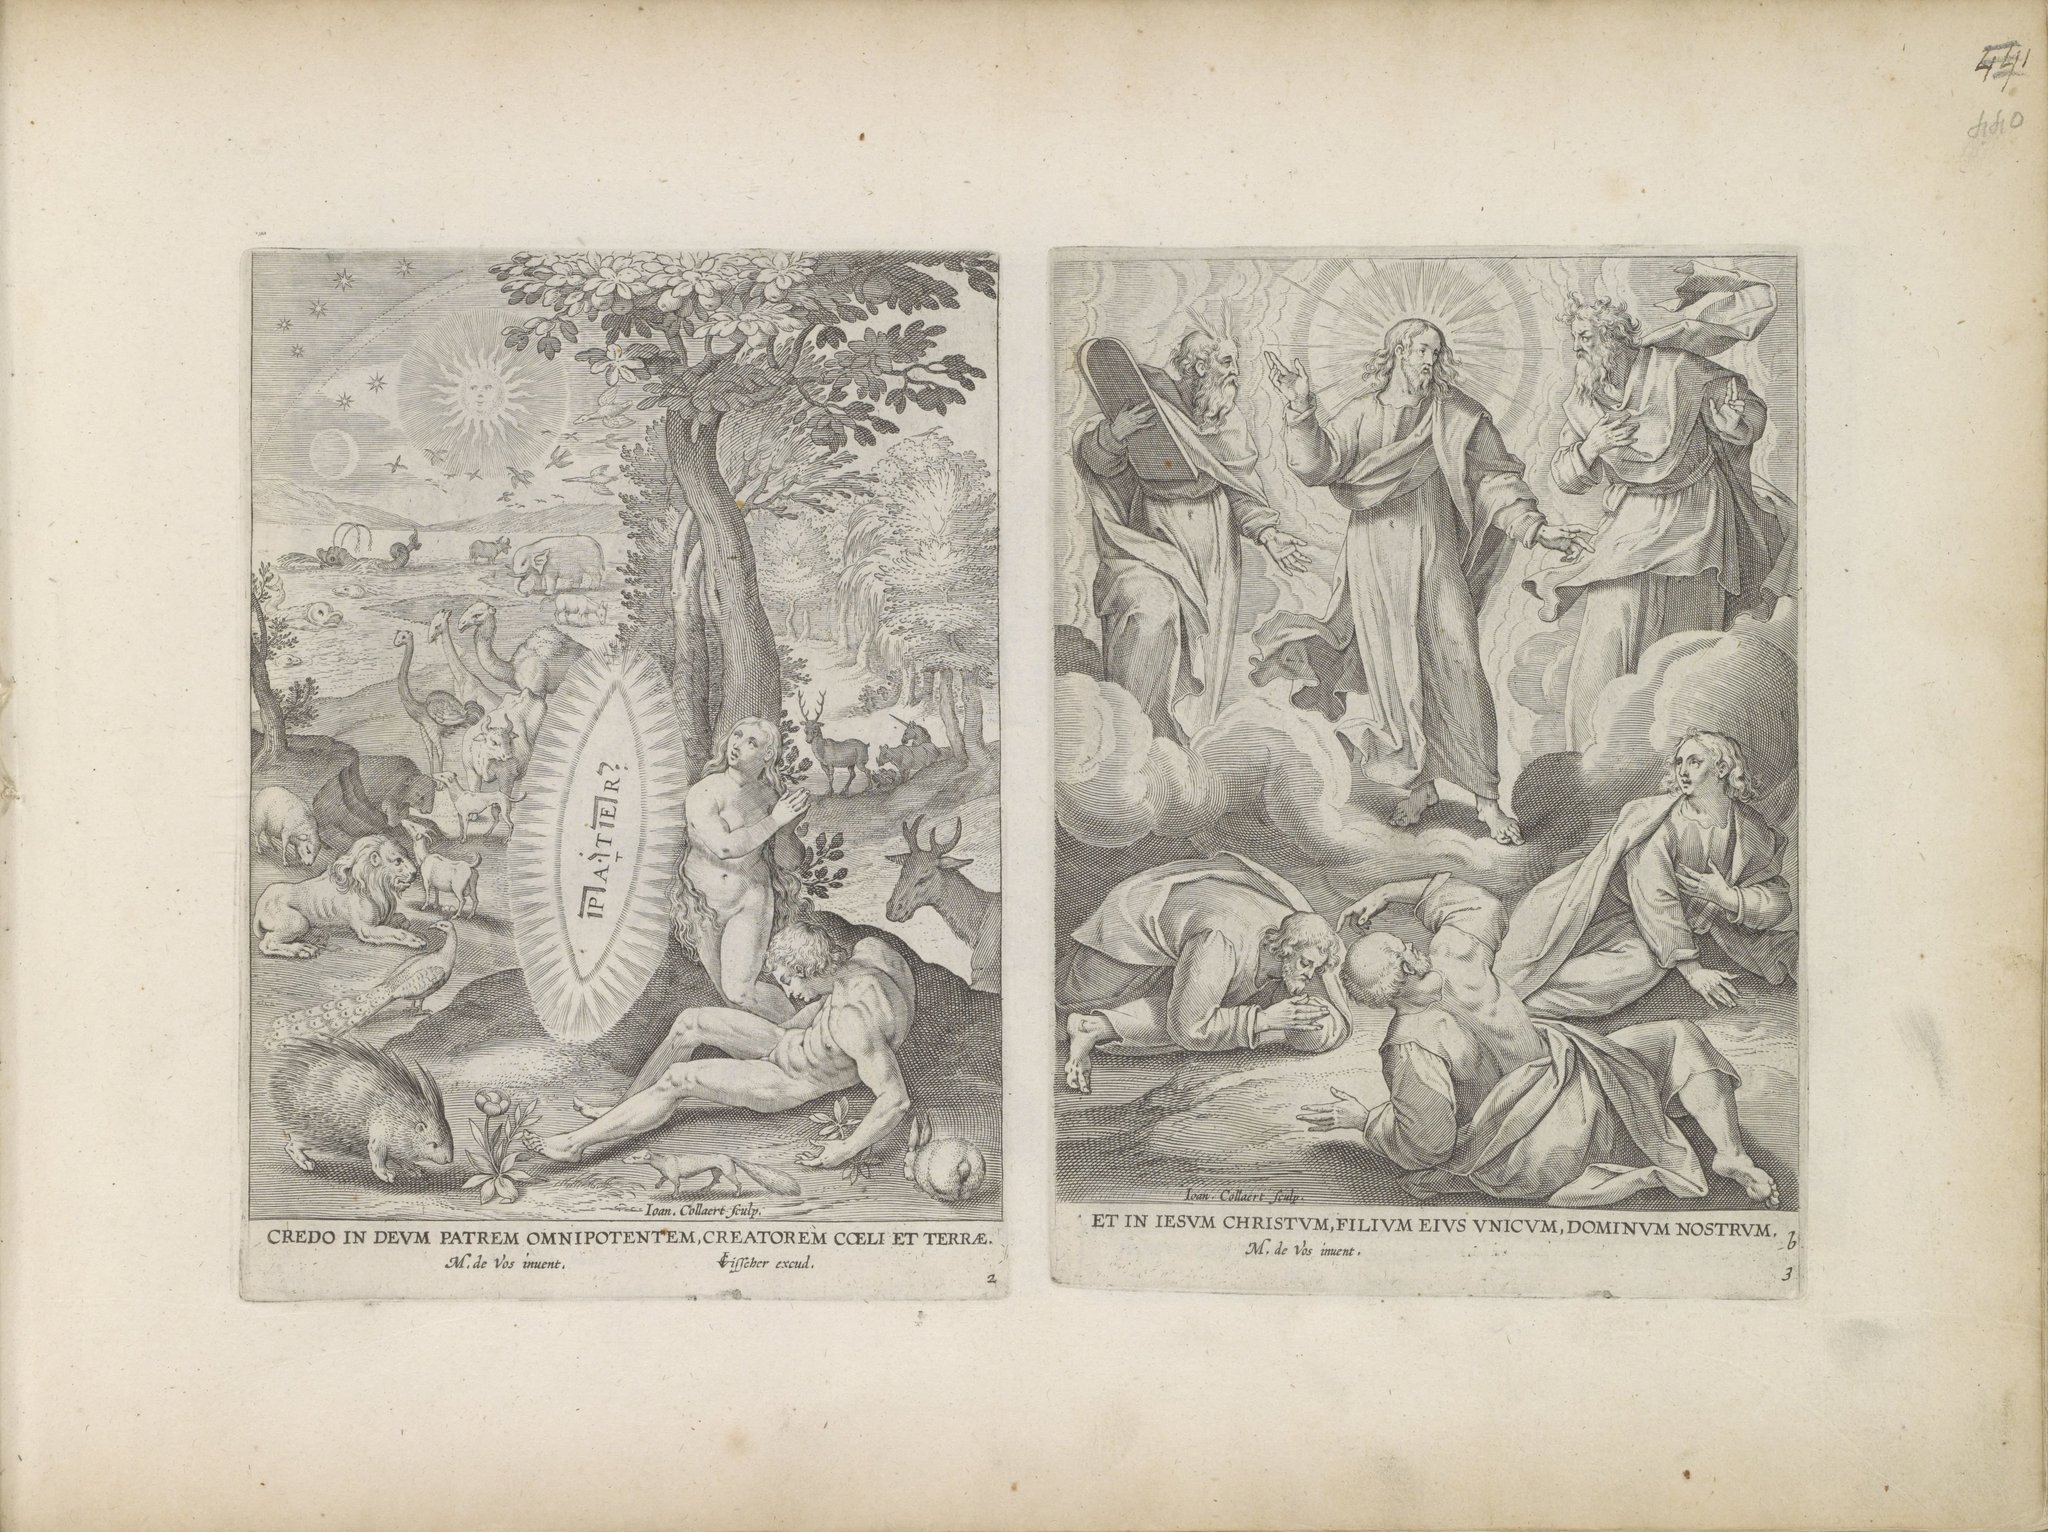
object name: album leaf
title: Apostolische geloofsbelijdenis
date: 1570-1618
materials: paper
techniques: engraving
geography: amsterdam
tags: 'et in jesum christum filium eius' ~ articles of faith, the transfiguration: moses and elijah appear on either side of christ on mount tabor (matthew 17:1-13; mark 9:2-13; luke 9:28-36)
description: Illustratie van het tweede geloofsartikel ([Ik geloof] in Jezus Christus, zijn enige Zoon, onze Heer) van de apostolische geloofsbelijdenis. De verheerlijking op de berg: Christus' gezicht straalt als de zon. Mozes en Elia verschijnen aan weerszijden van Christus en spreken met hem. Op de berg zitten Johannes, Petrus en Jakobus. Deze prent maakt deel uit van een album.